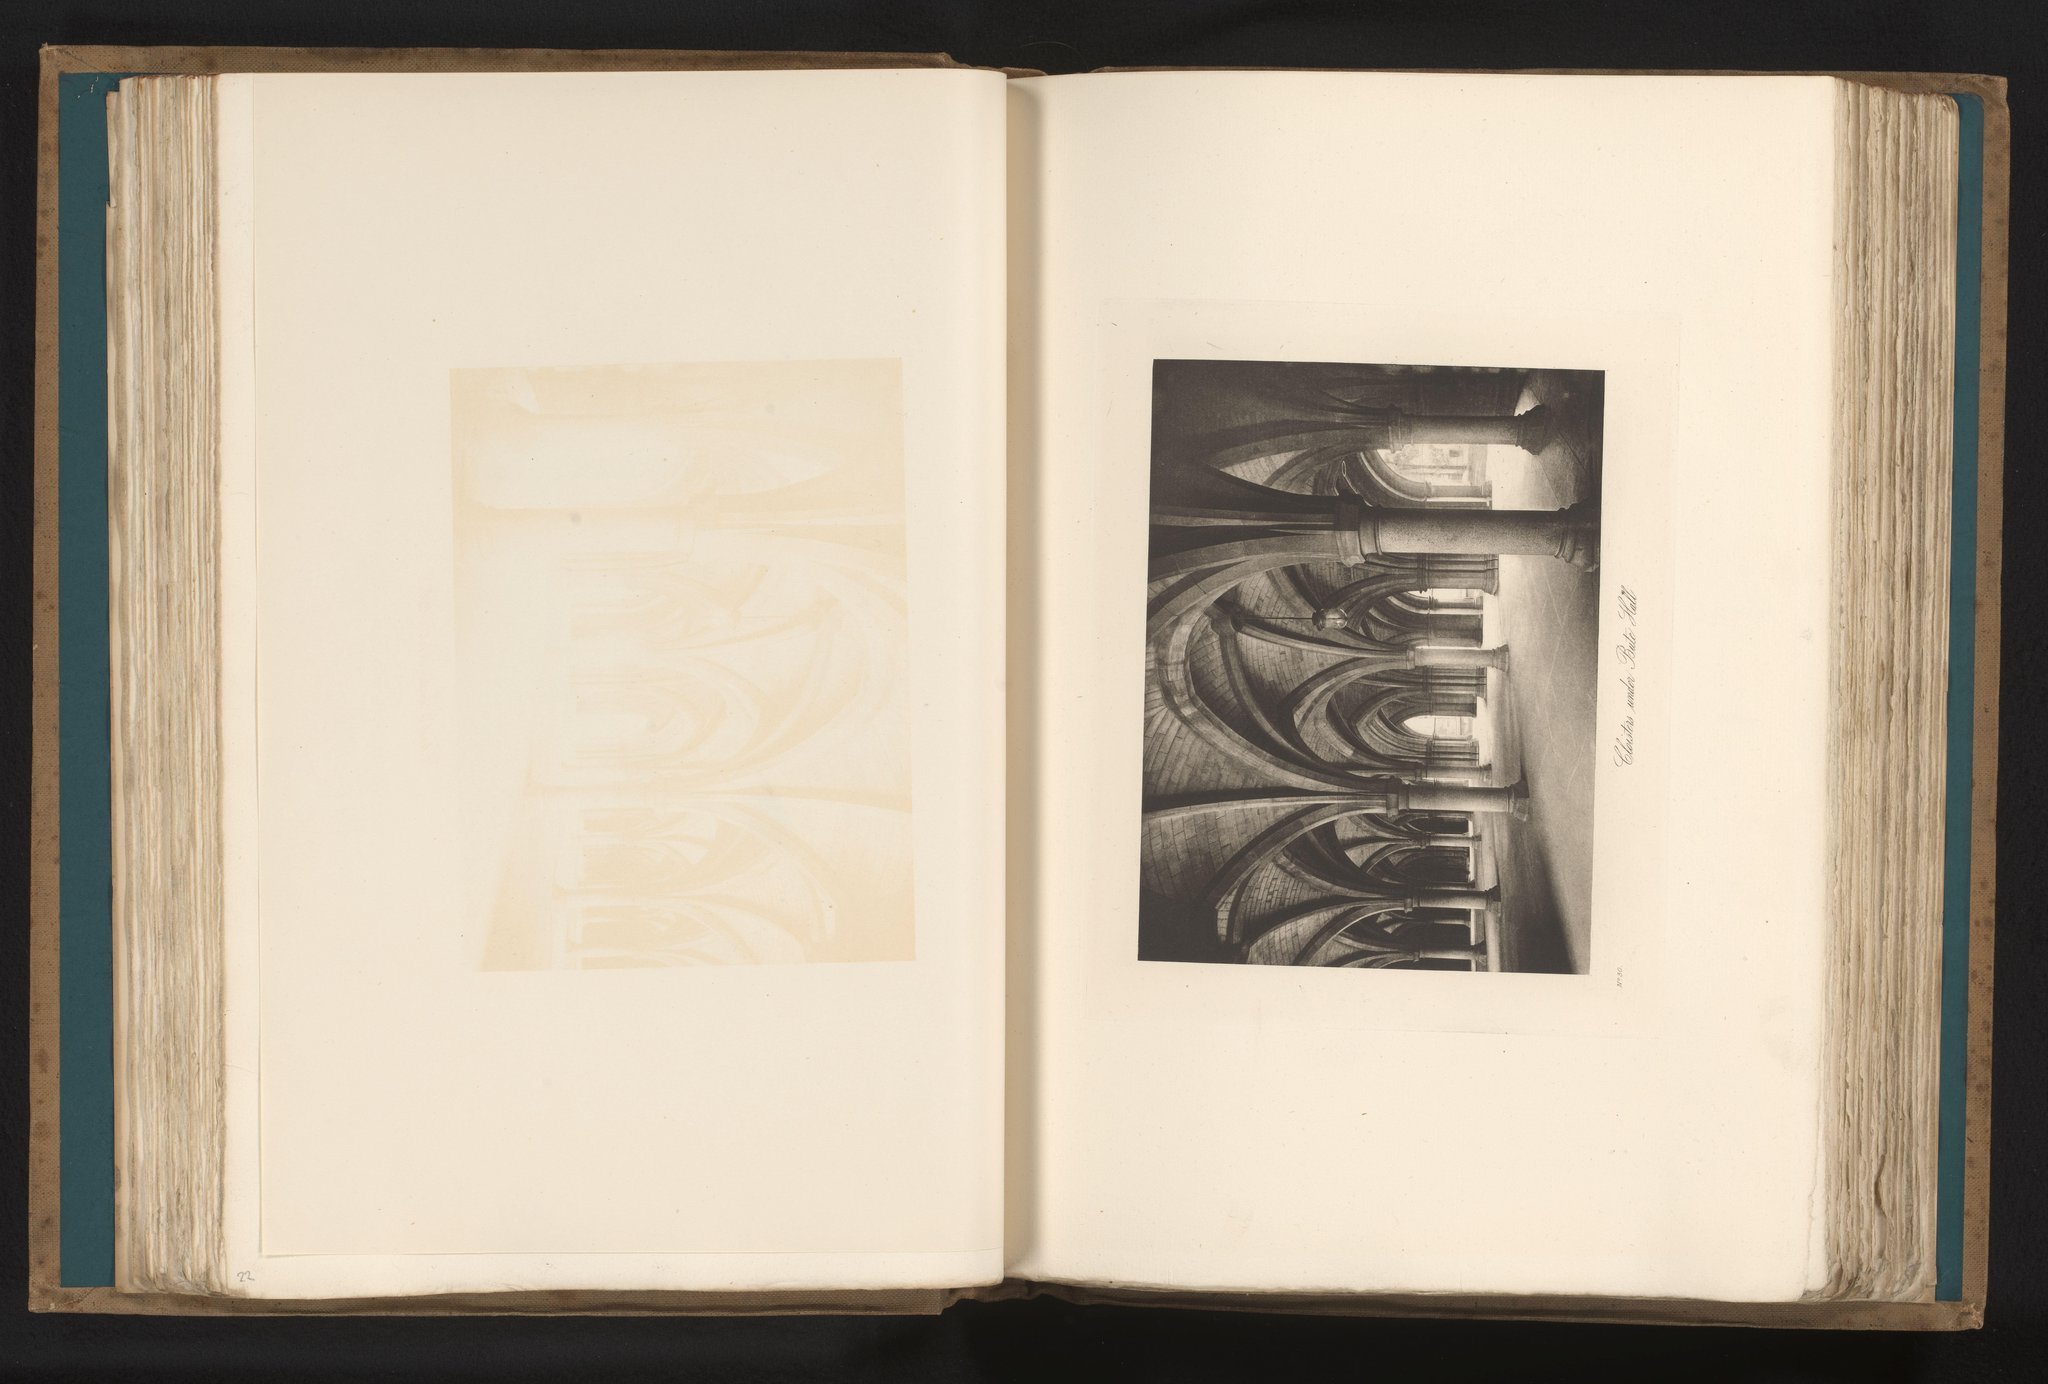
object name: photomechanical print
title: Cloisters under Bute Hall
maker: Anonymous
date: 1886-1891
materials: paper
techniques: photoaquatint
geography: glasgow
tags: university (+ building ~ education, tuition), courtyard, glasgow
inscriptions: inscription: ‘No.30’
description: Prent op zesentwintigste ongenummerde pagina na pagina xxxiii.